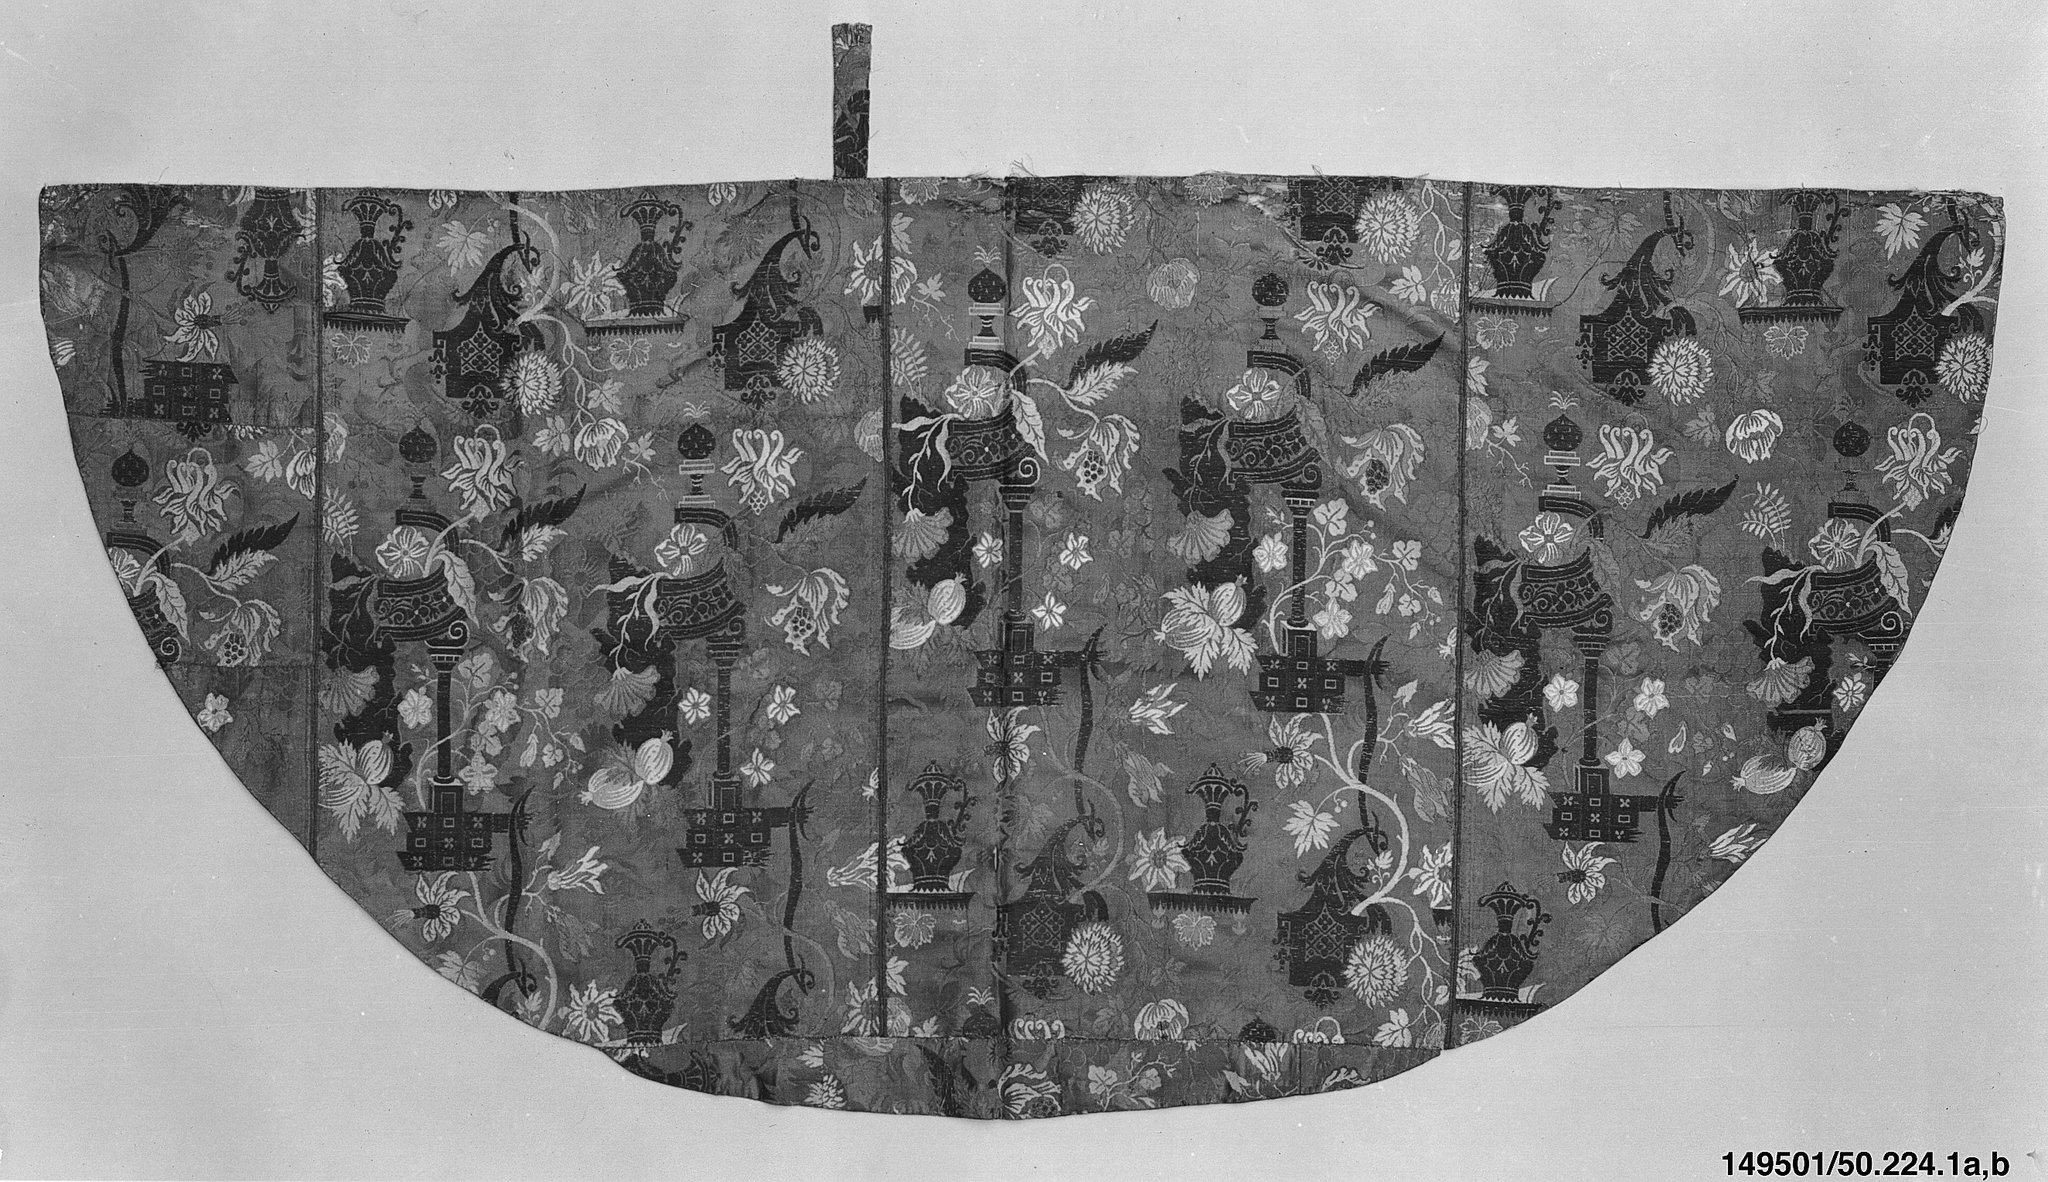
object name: piece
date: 1710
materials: metal thread, silk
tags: flowers,leaves